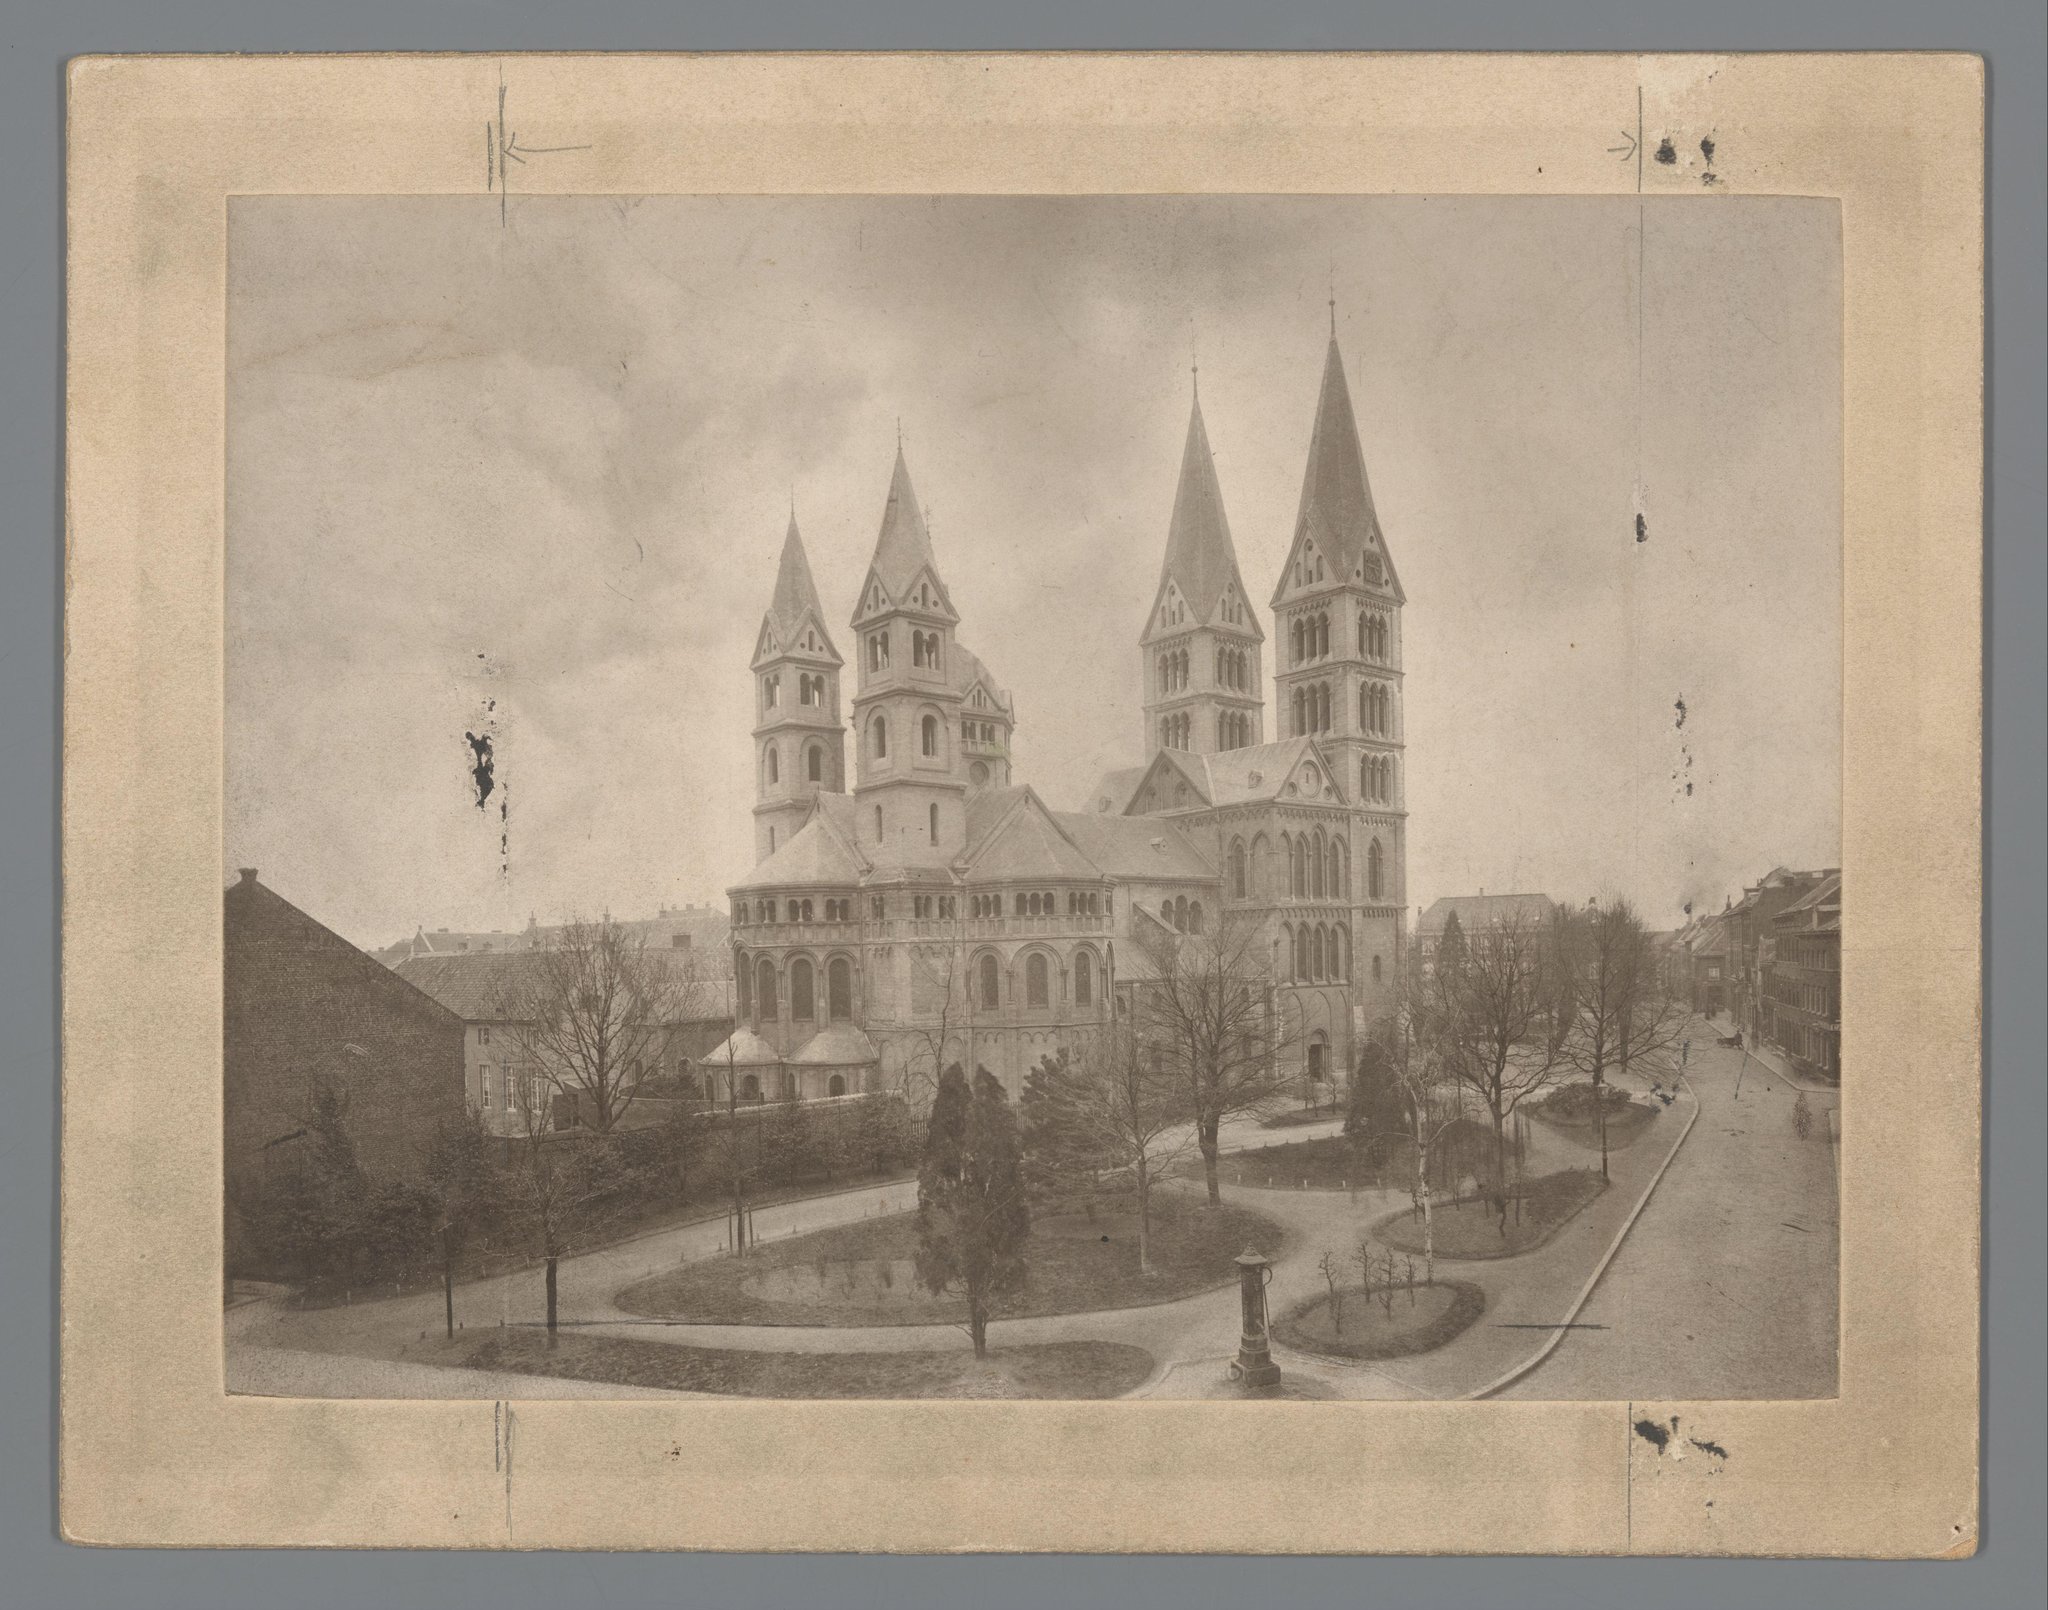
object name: photograph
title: Gezicht op de Munsterkerk te Roermond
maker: Anonymous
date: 1890-1910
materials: cardboard, photographic support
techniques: collodion silver print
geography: roermond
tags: church (exterior)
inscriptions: annotation: ‘A. Herman/ Roermond/ Munsterkerk/ top’, number: ‘147’